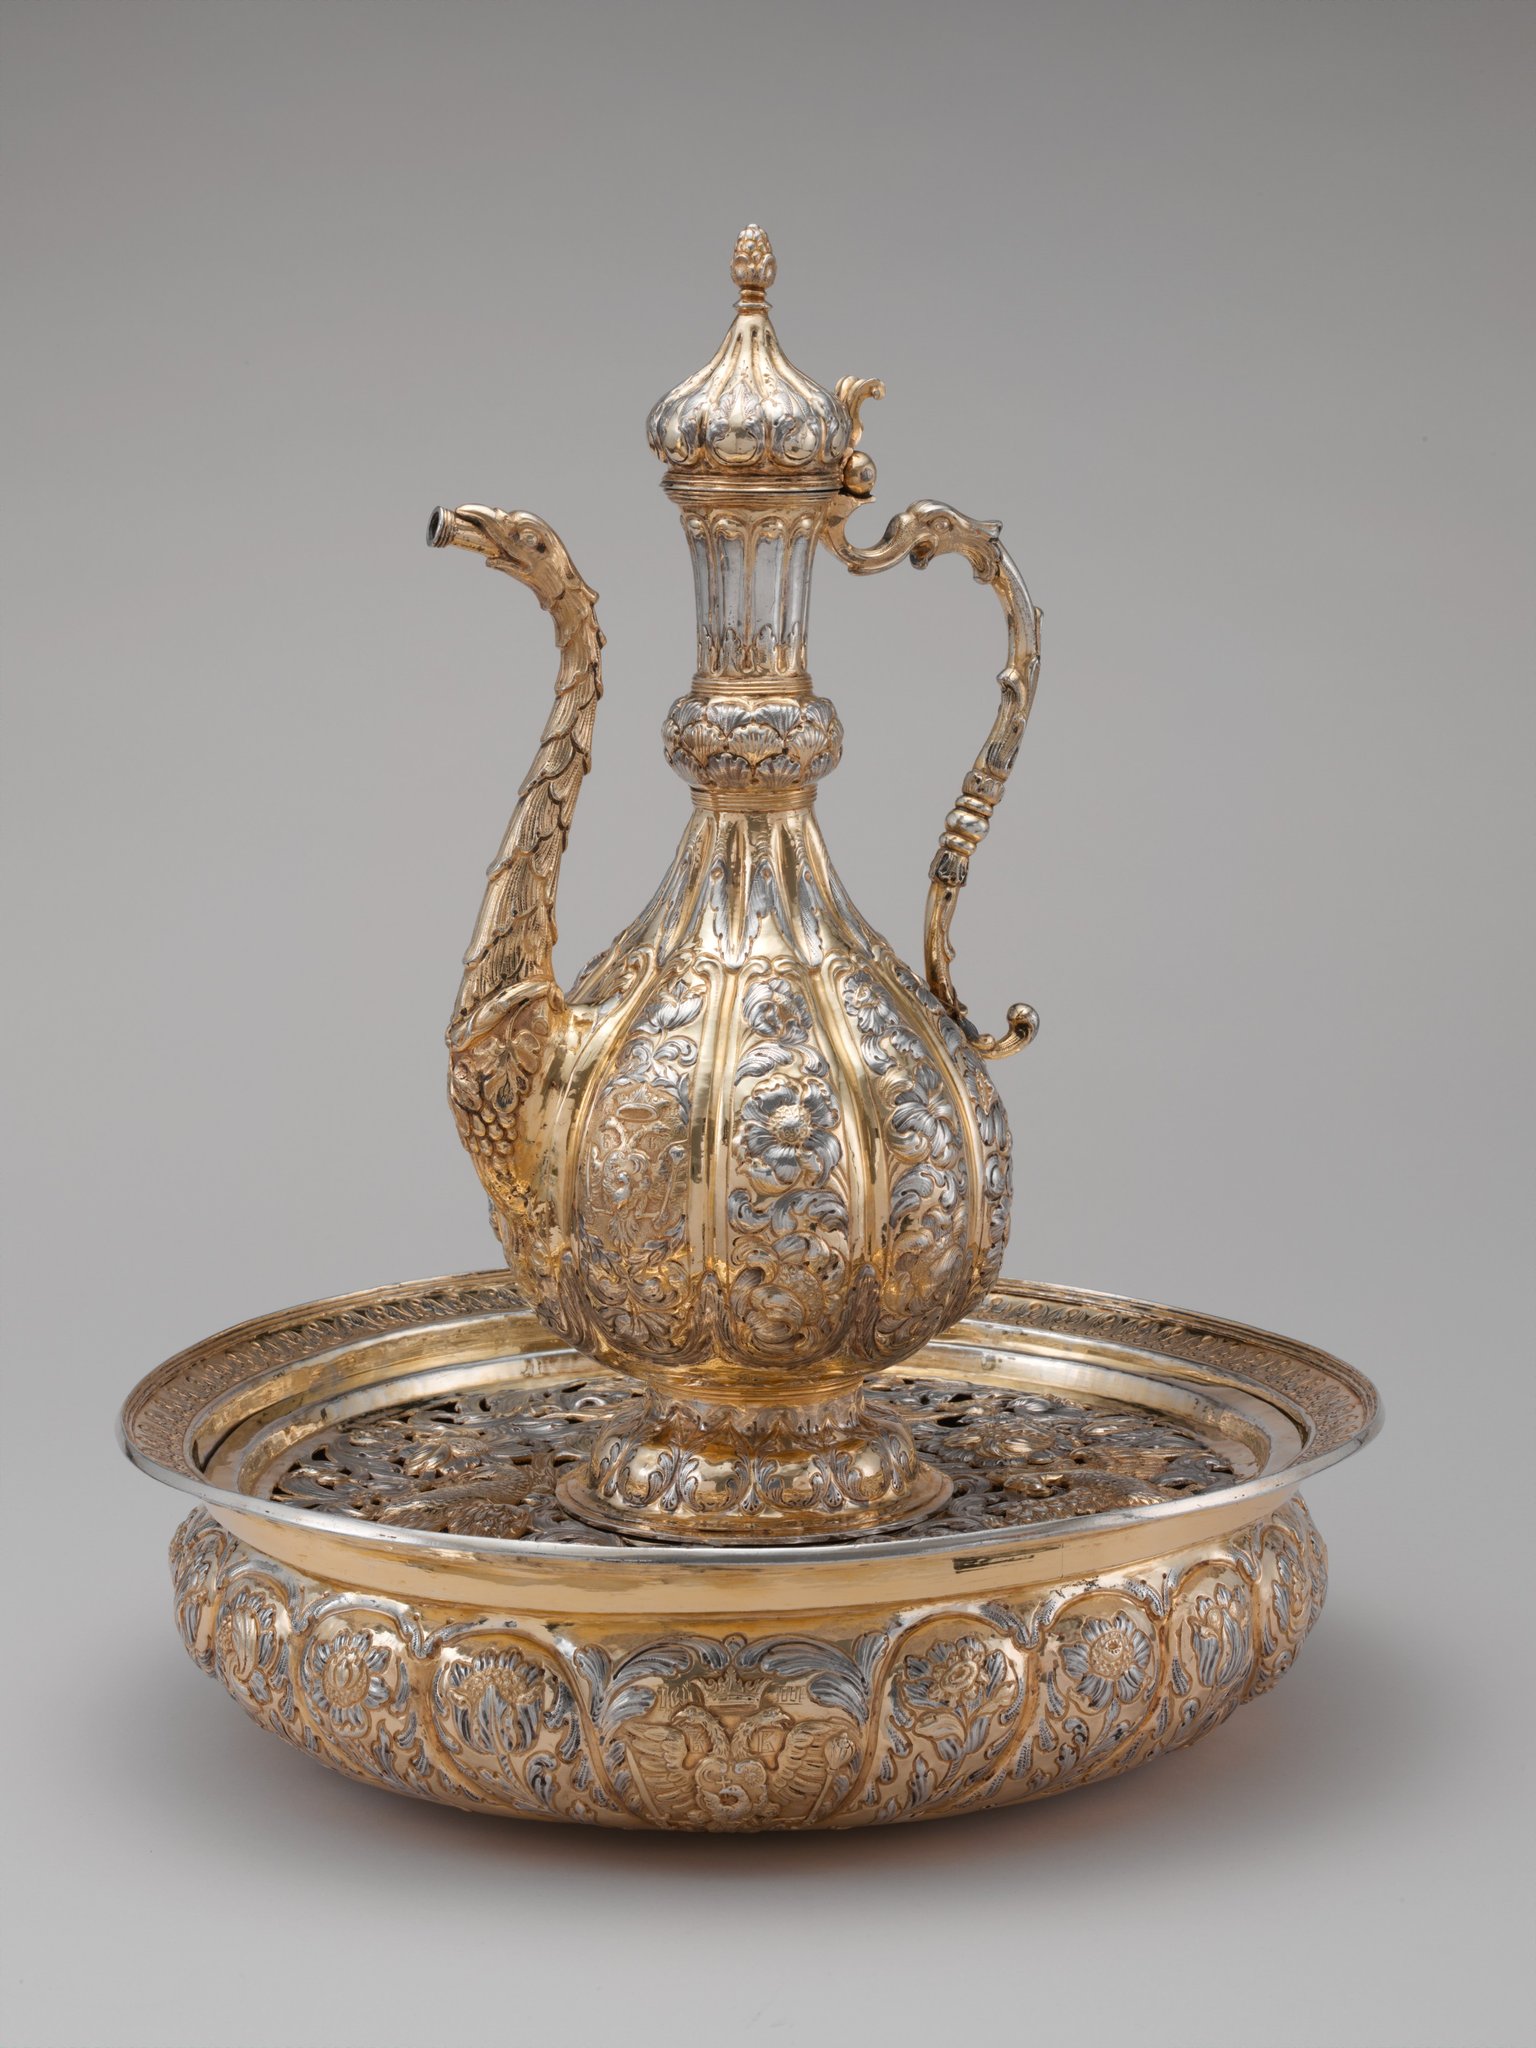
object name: ewer and basin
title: Ewer and basin (lavabo set)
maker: chisinau court workshop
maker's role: maker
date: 1680-1685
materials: silver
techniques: gilding